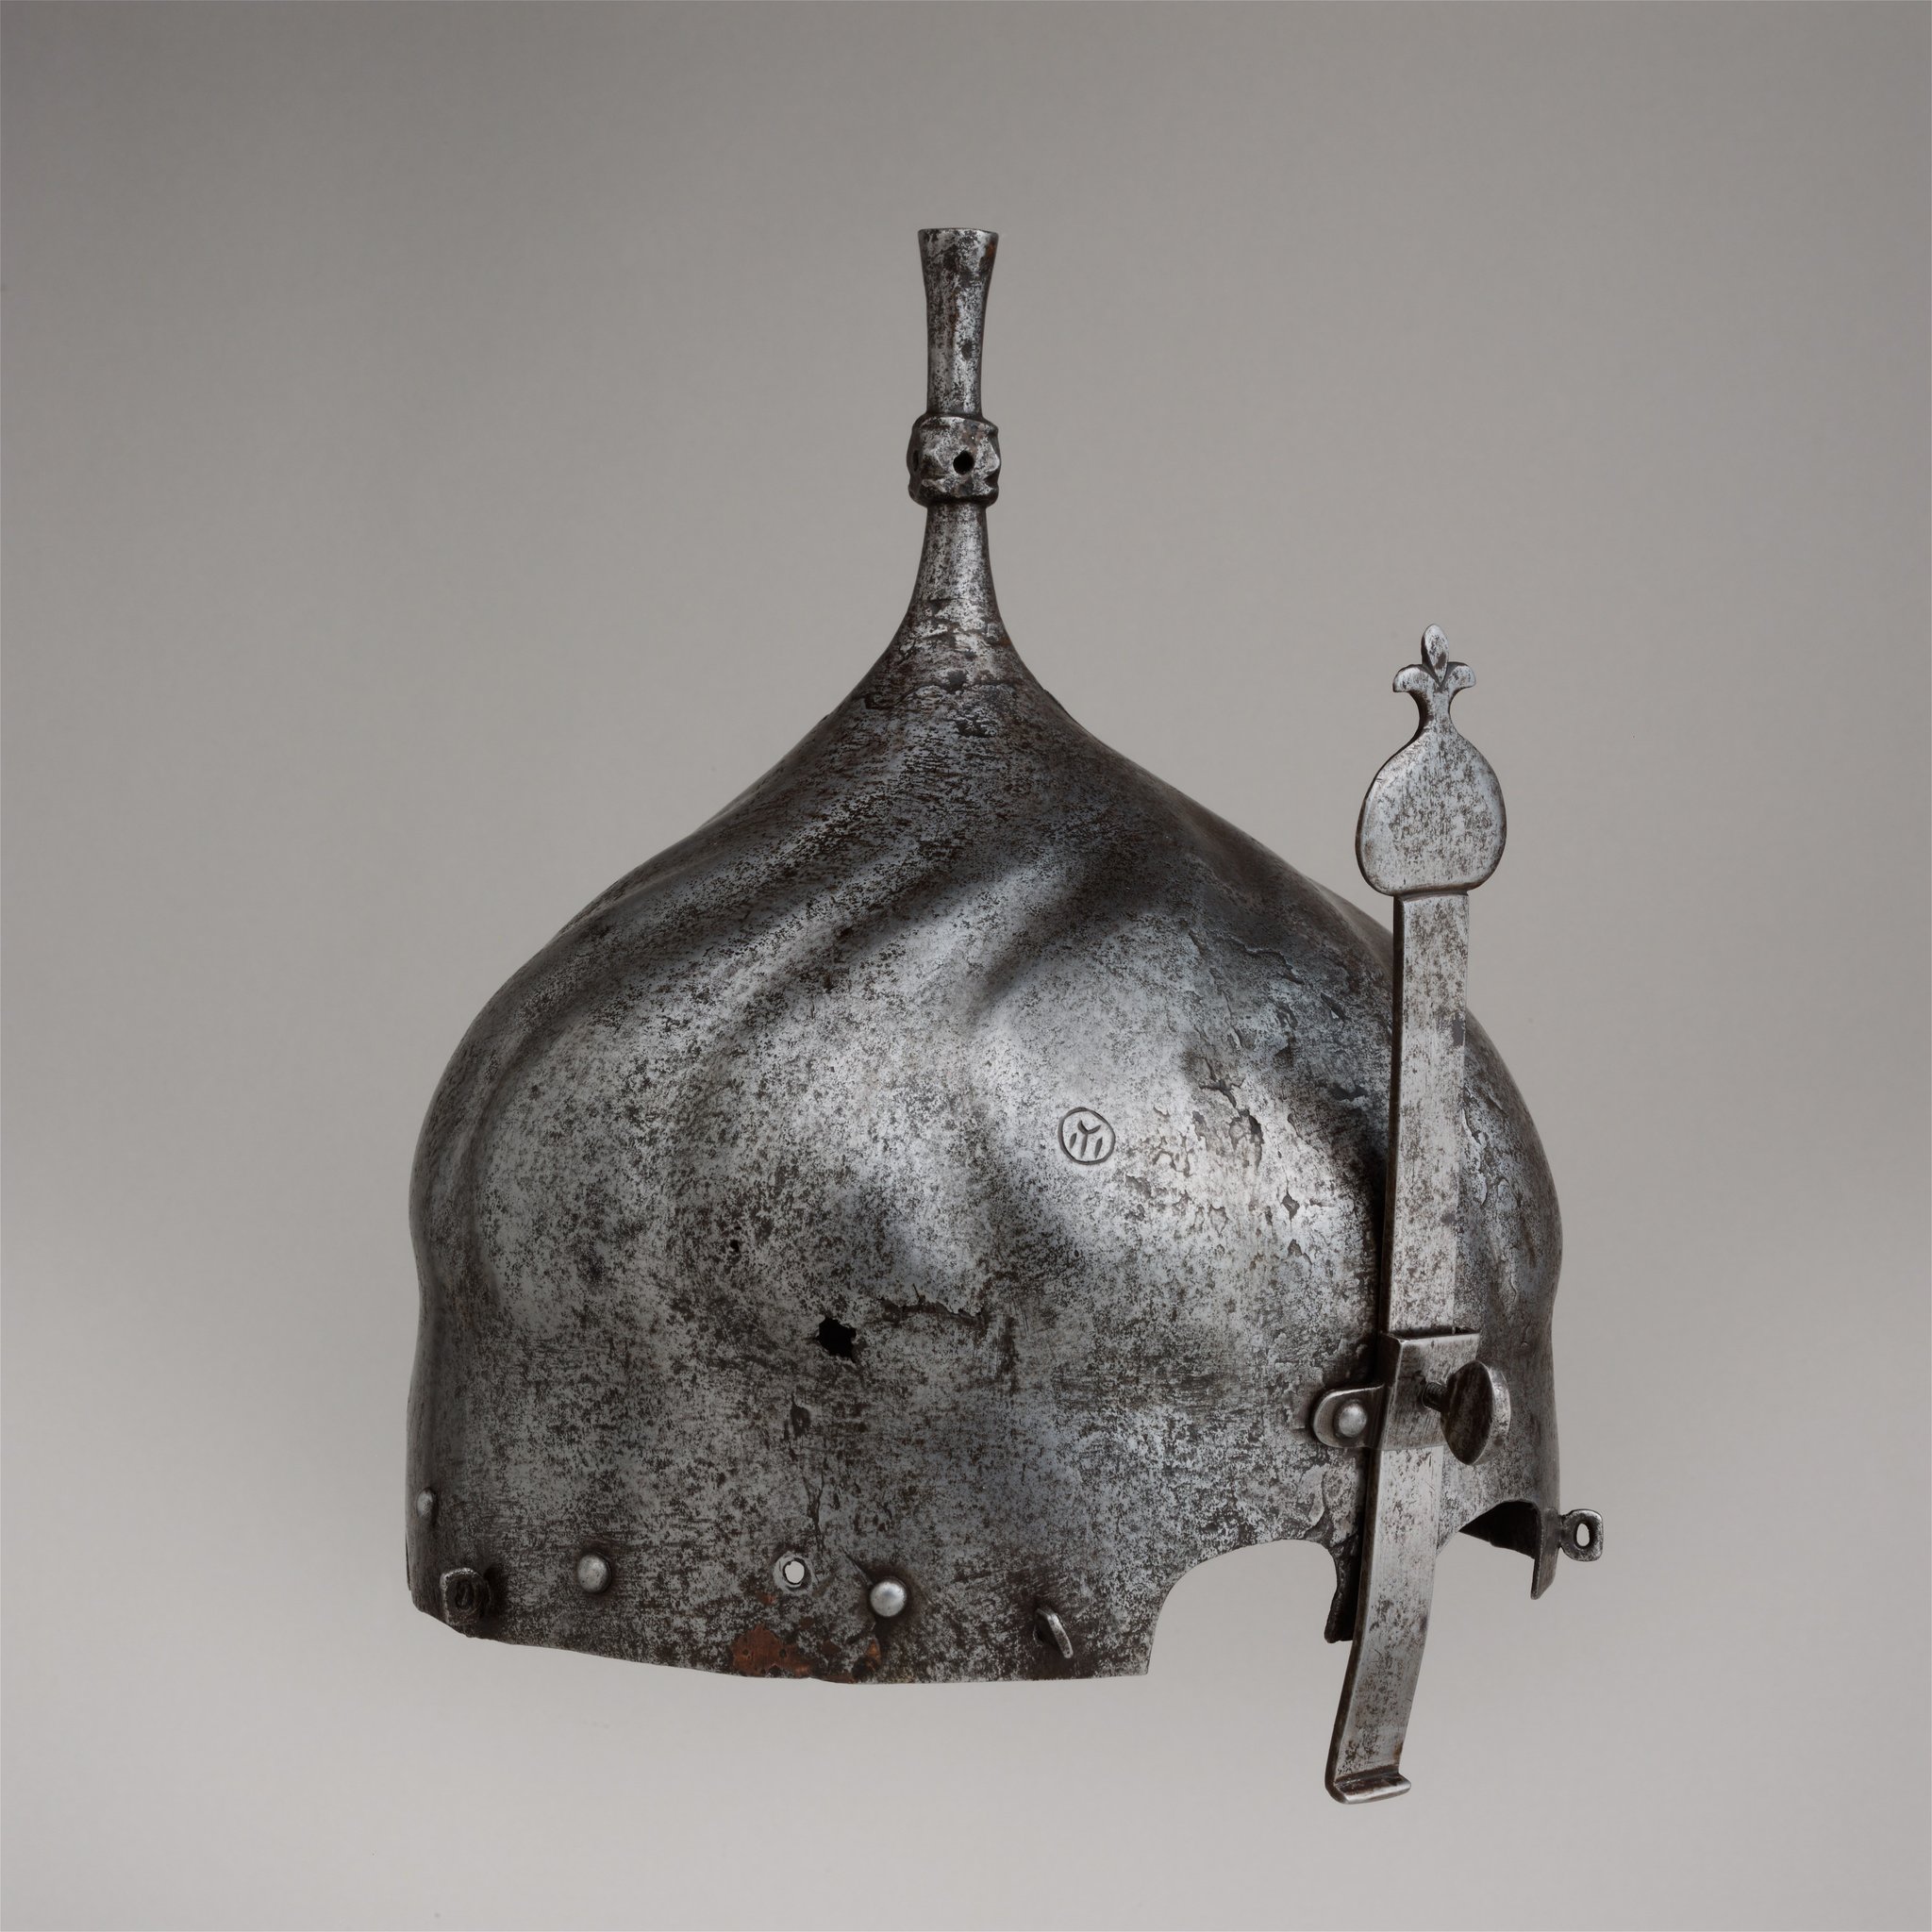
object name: helmet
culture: turkish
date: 1501-1600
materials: iron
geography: ottoman empire